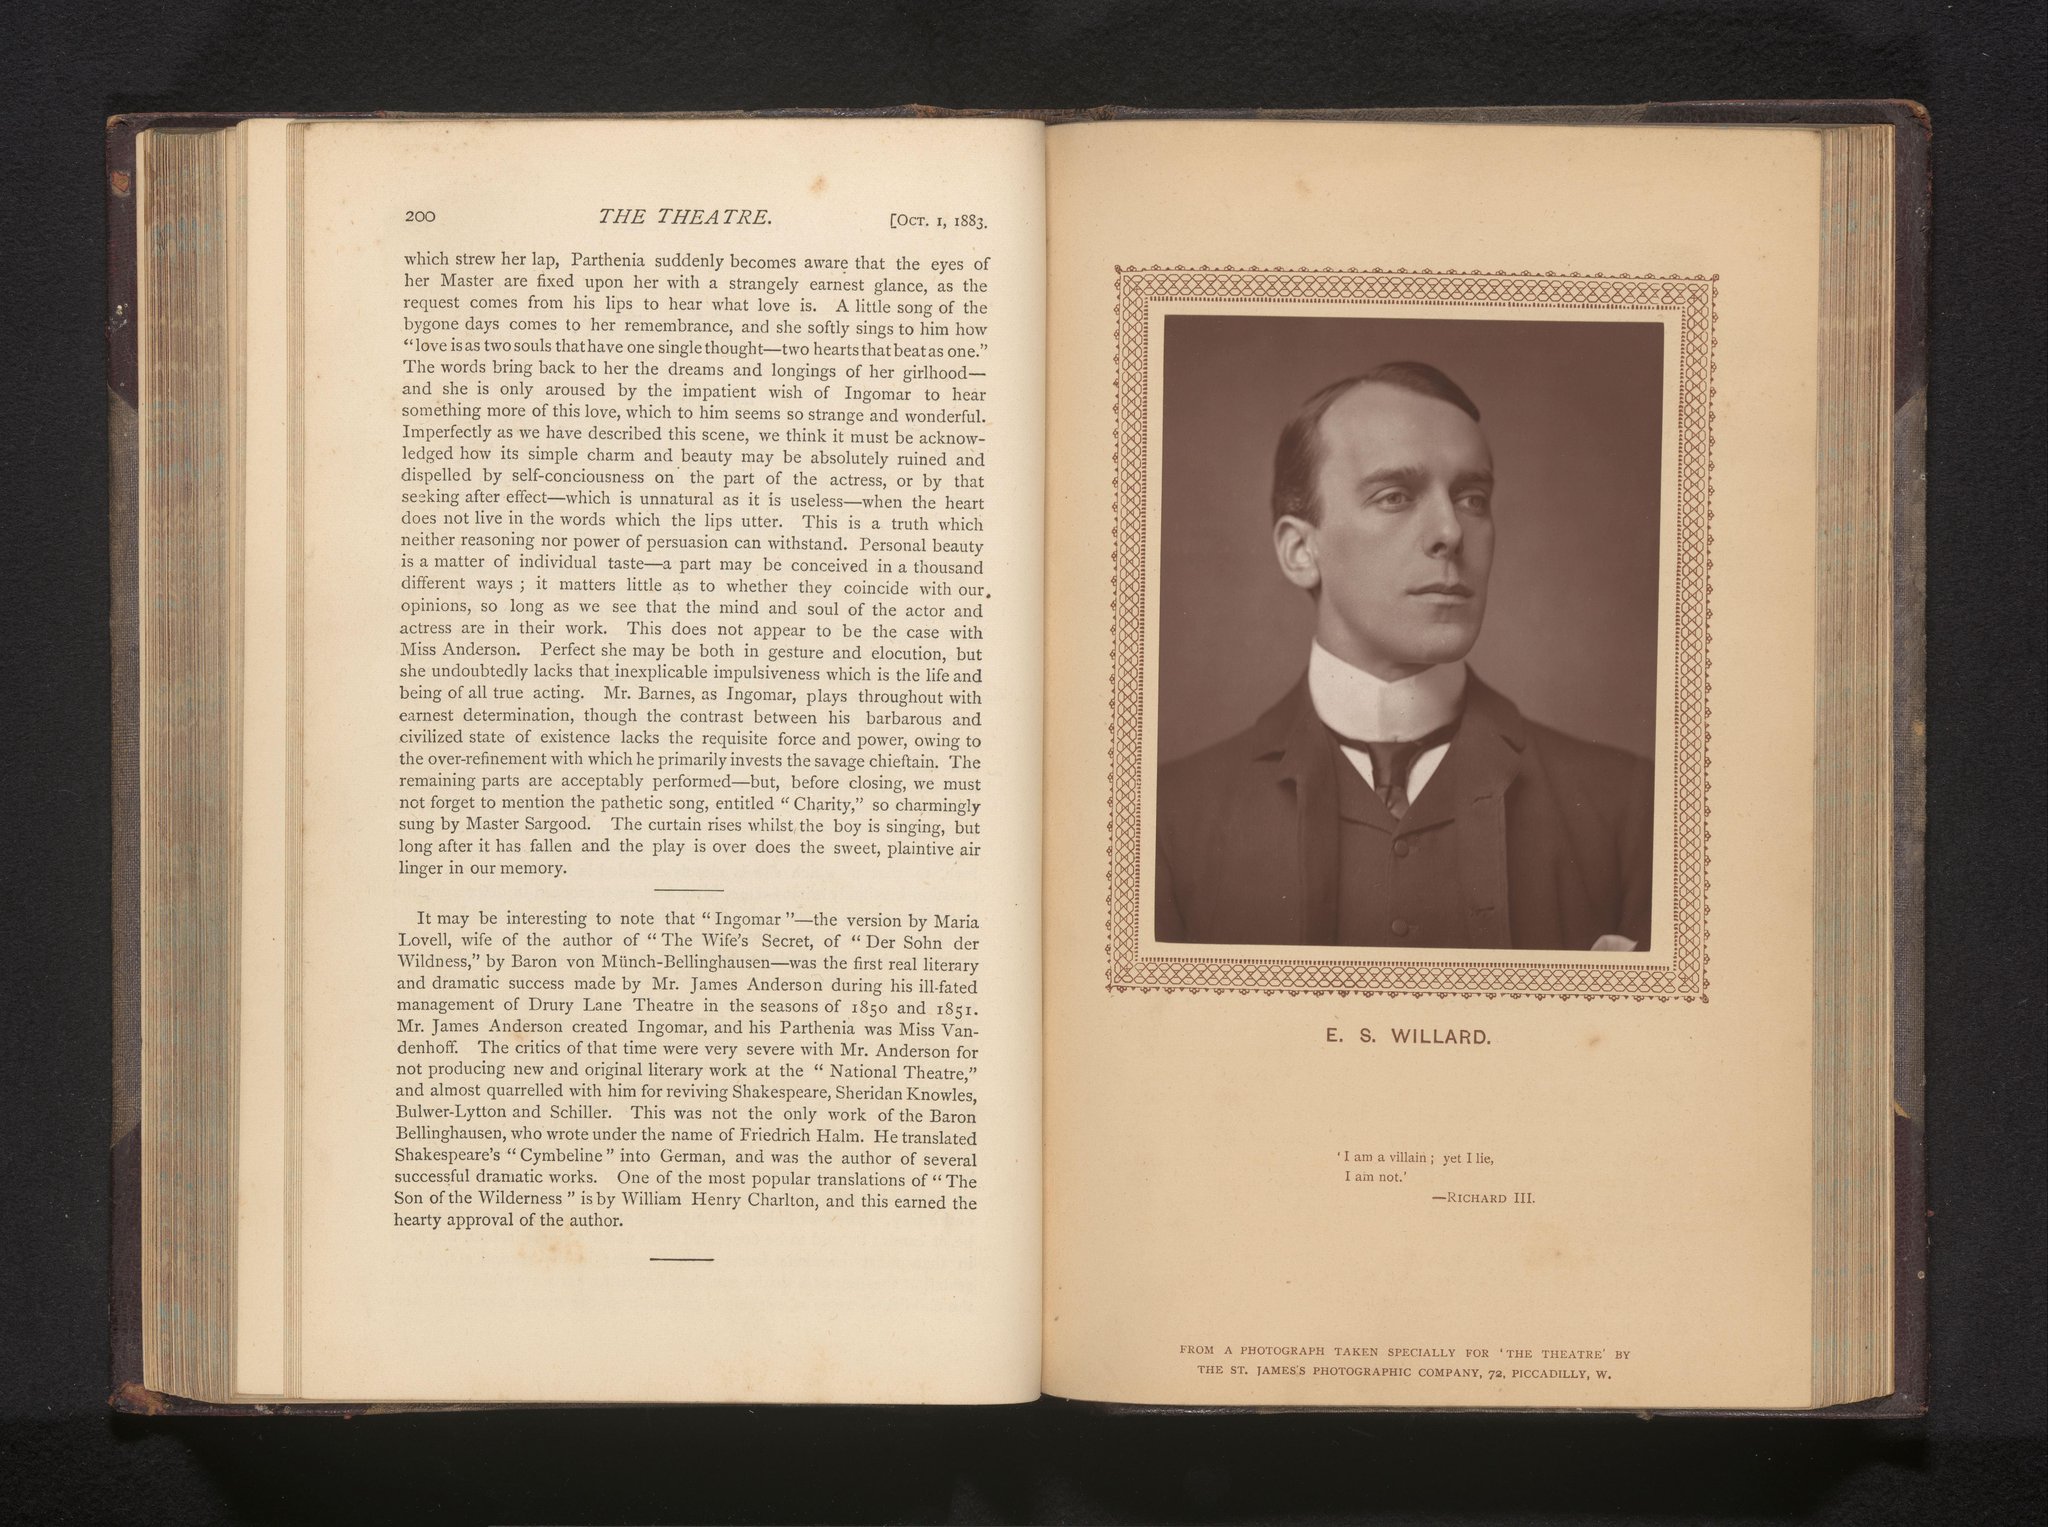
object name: page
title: Portret van Edward Smith Willard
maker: Anonymous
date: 1878-1883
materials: paper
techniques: woodburytype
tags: adult man, historical persons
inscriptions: inscription: ‘'I am a villain; yet I lie,/ I am not.'/ - Richard III.’